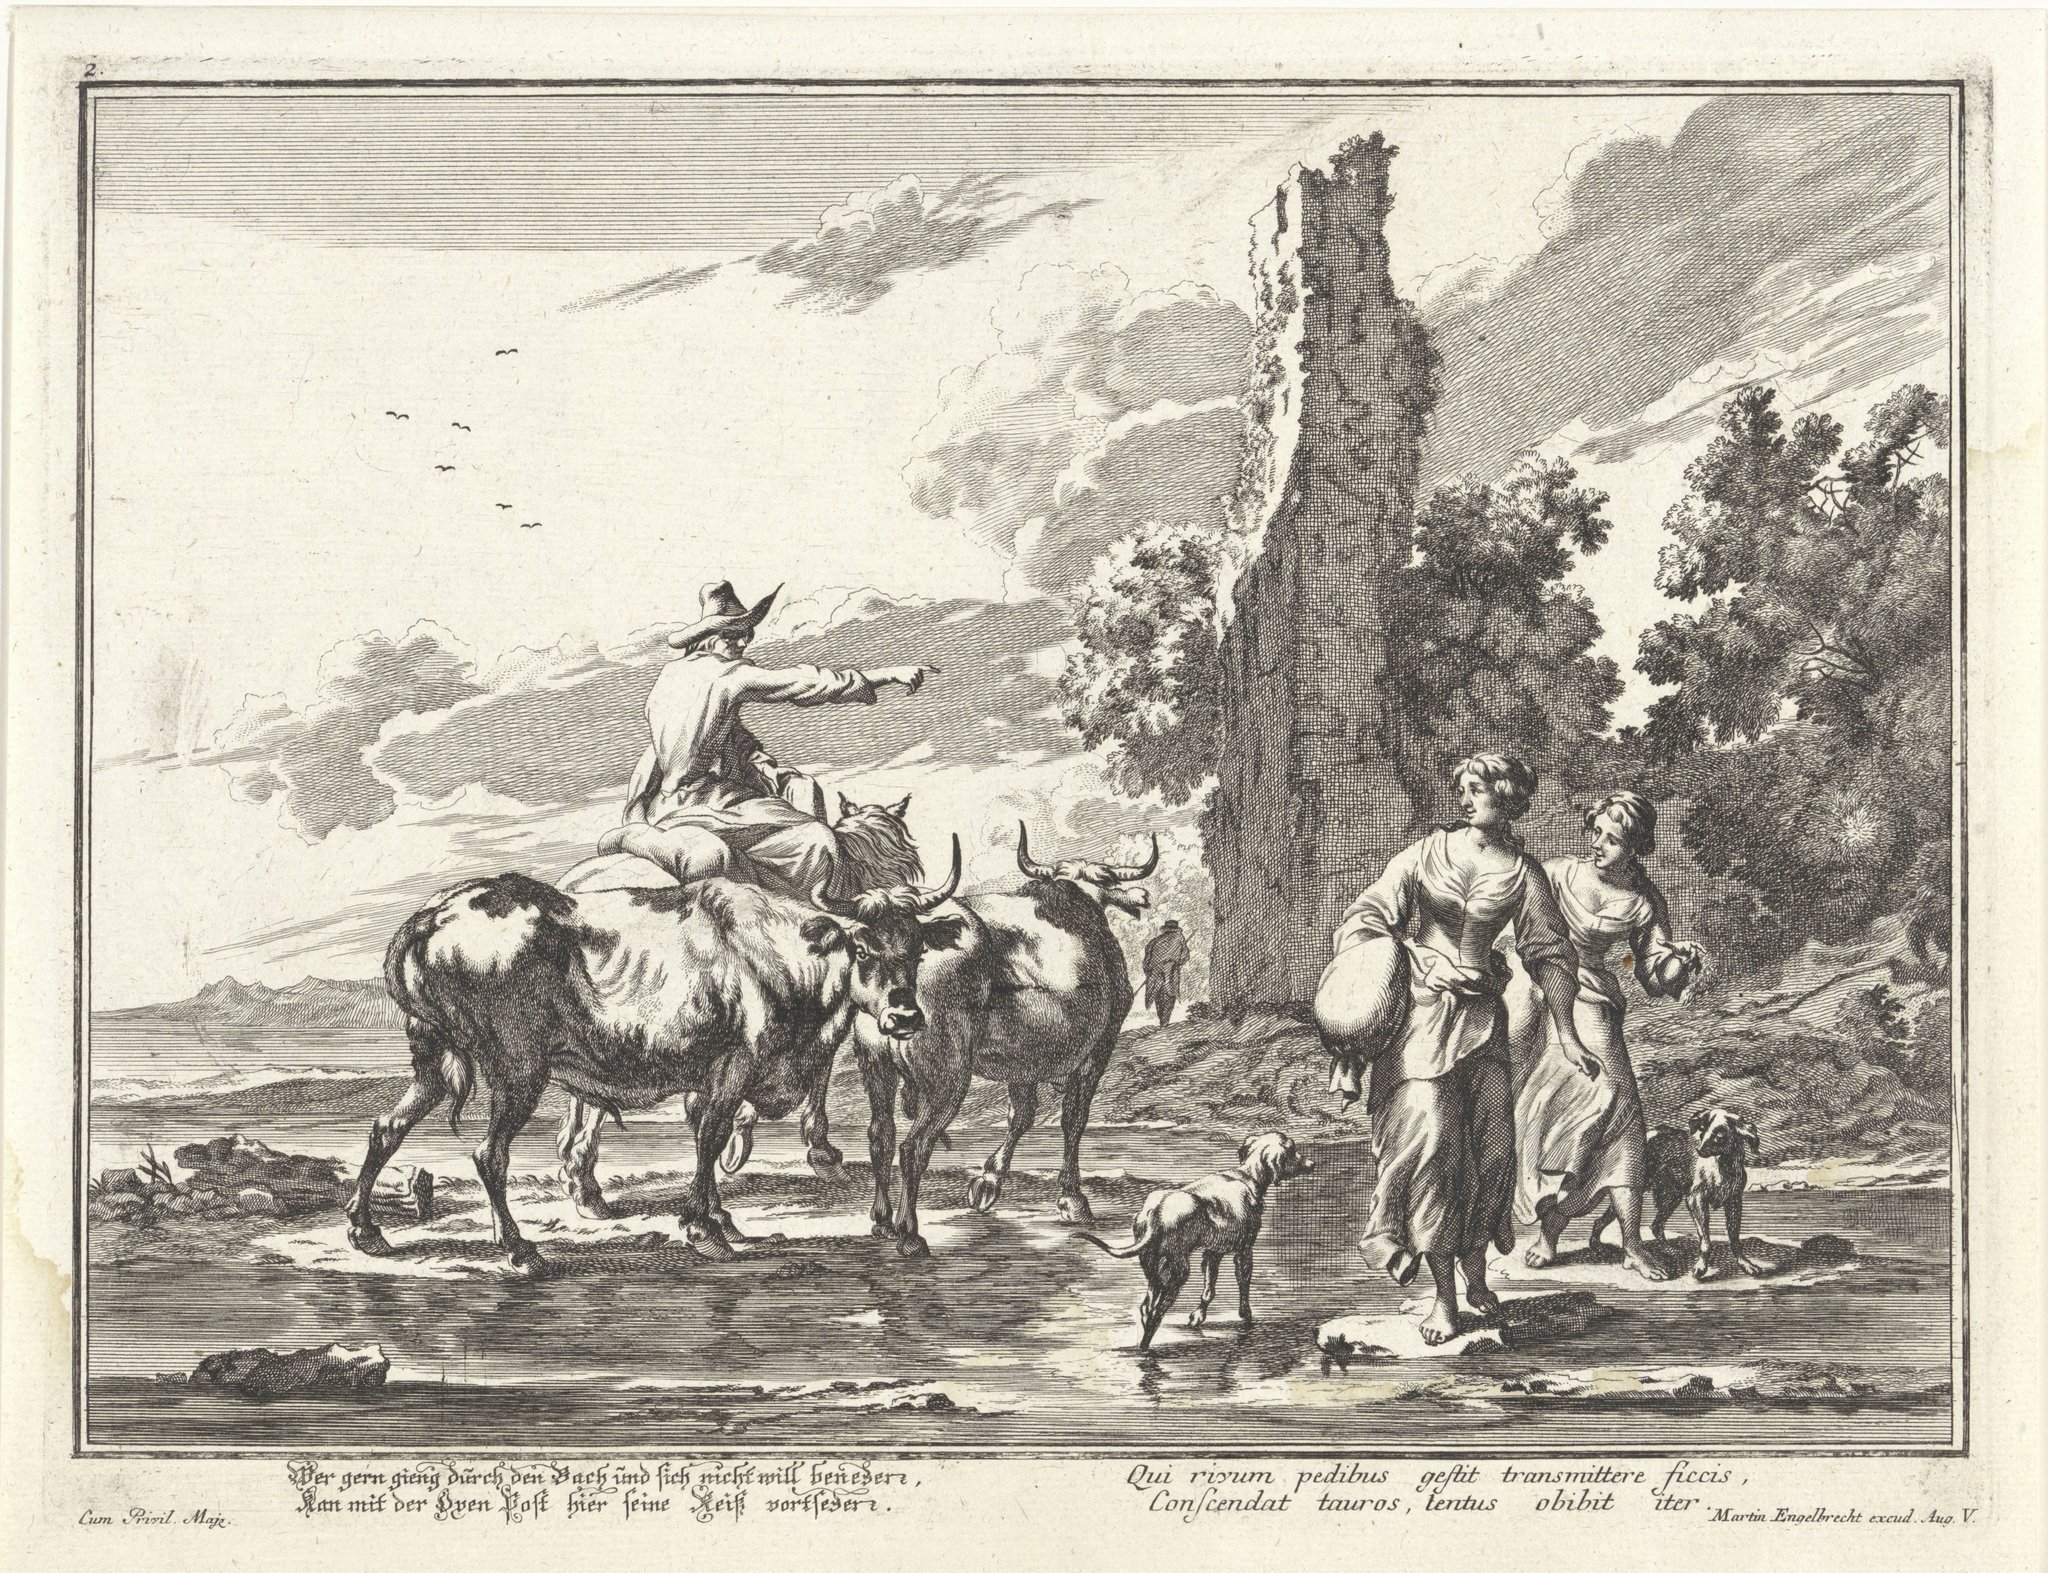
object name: print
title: Herder en herderinnen in een voorde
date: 1699-1756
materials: paper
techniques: engraving, etching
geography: germany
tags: cow, herding, herdsman, herdswoman, shepherd, shepherdess, cowherd, etc., ford, index finger forwards, pointing, indicating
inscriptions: collector's mark: Lugt 2228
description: In een voorde wijst een herder te paard twee herderinnen met honden iets aan. De herder heeft twee koeien bij zich.